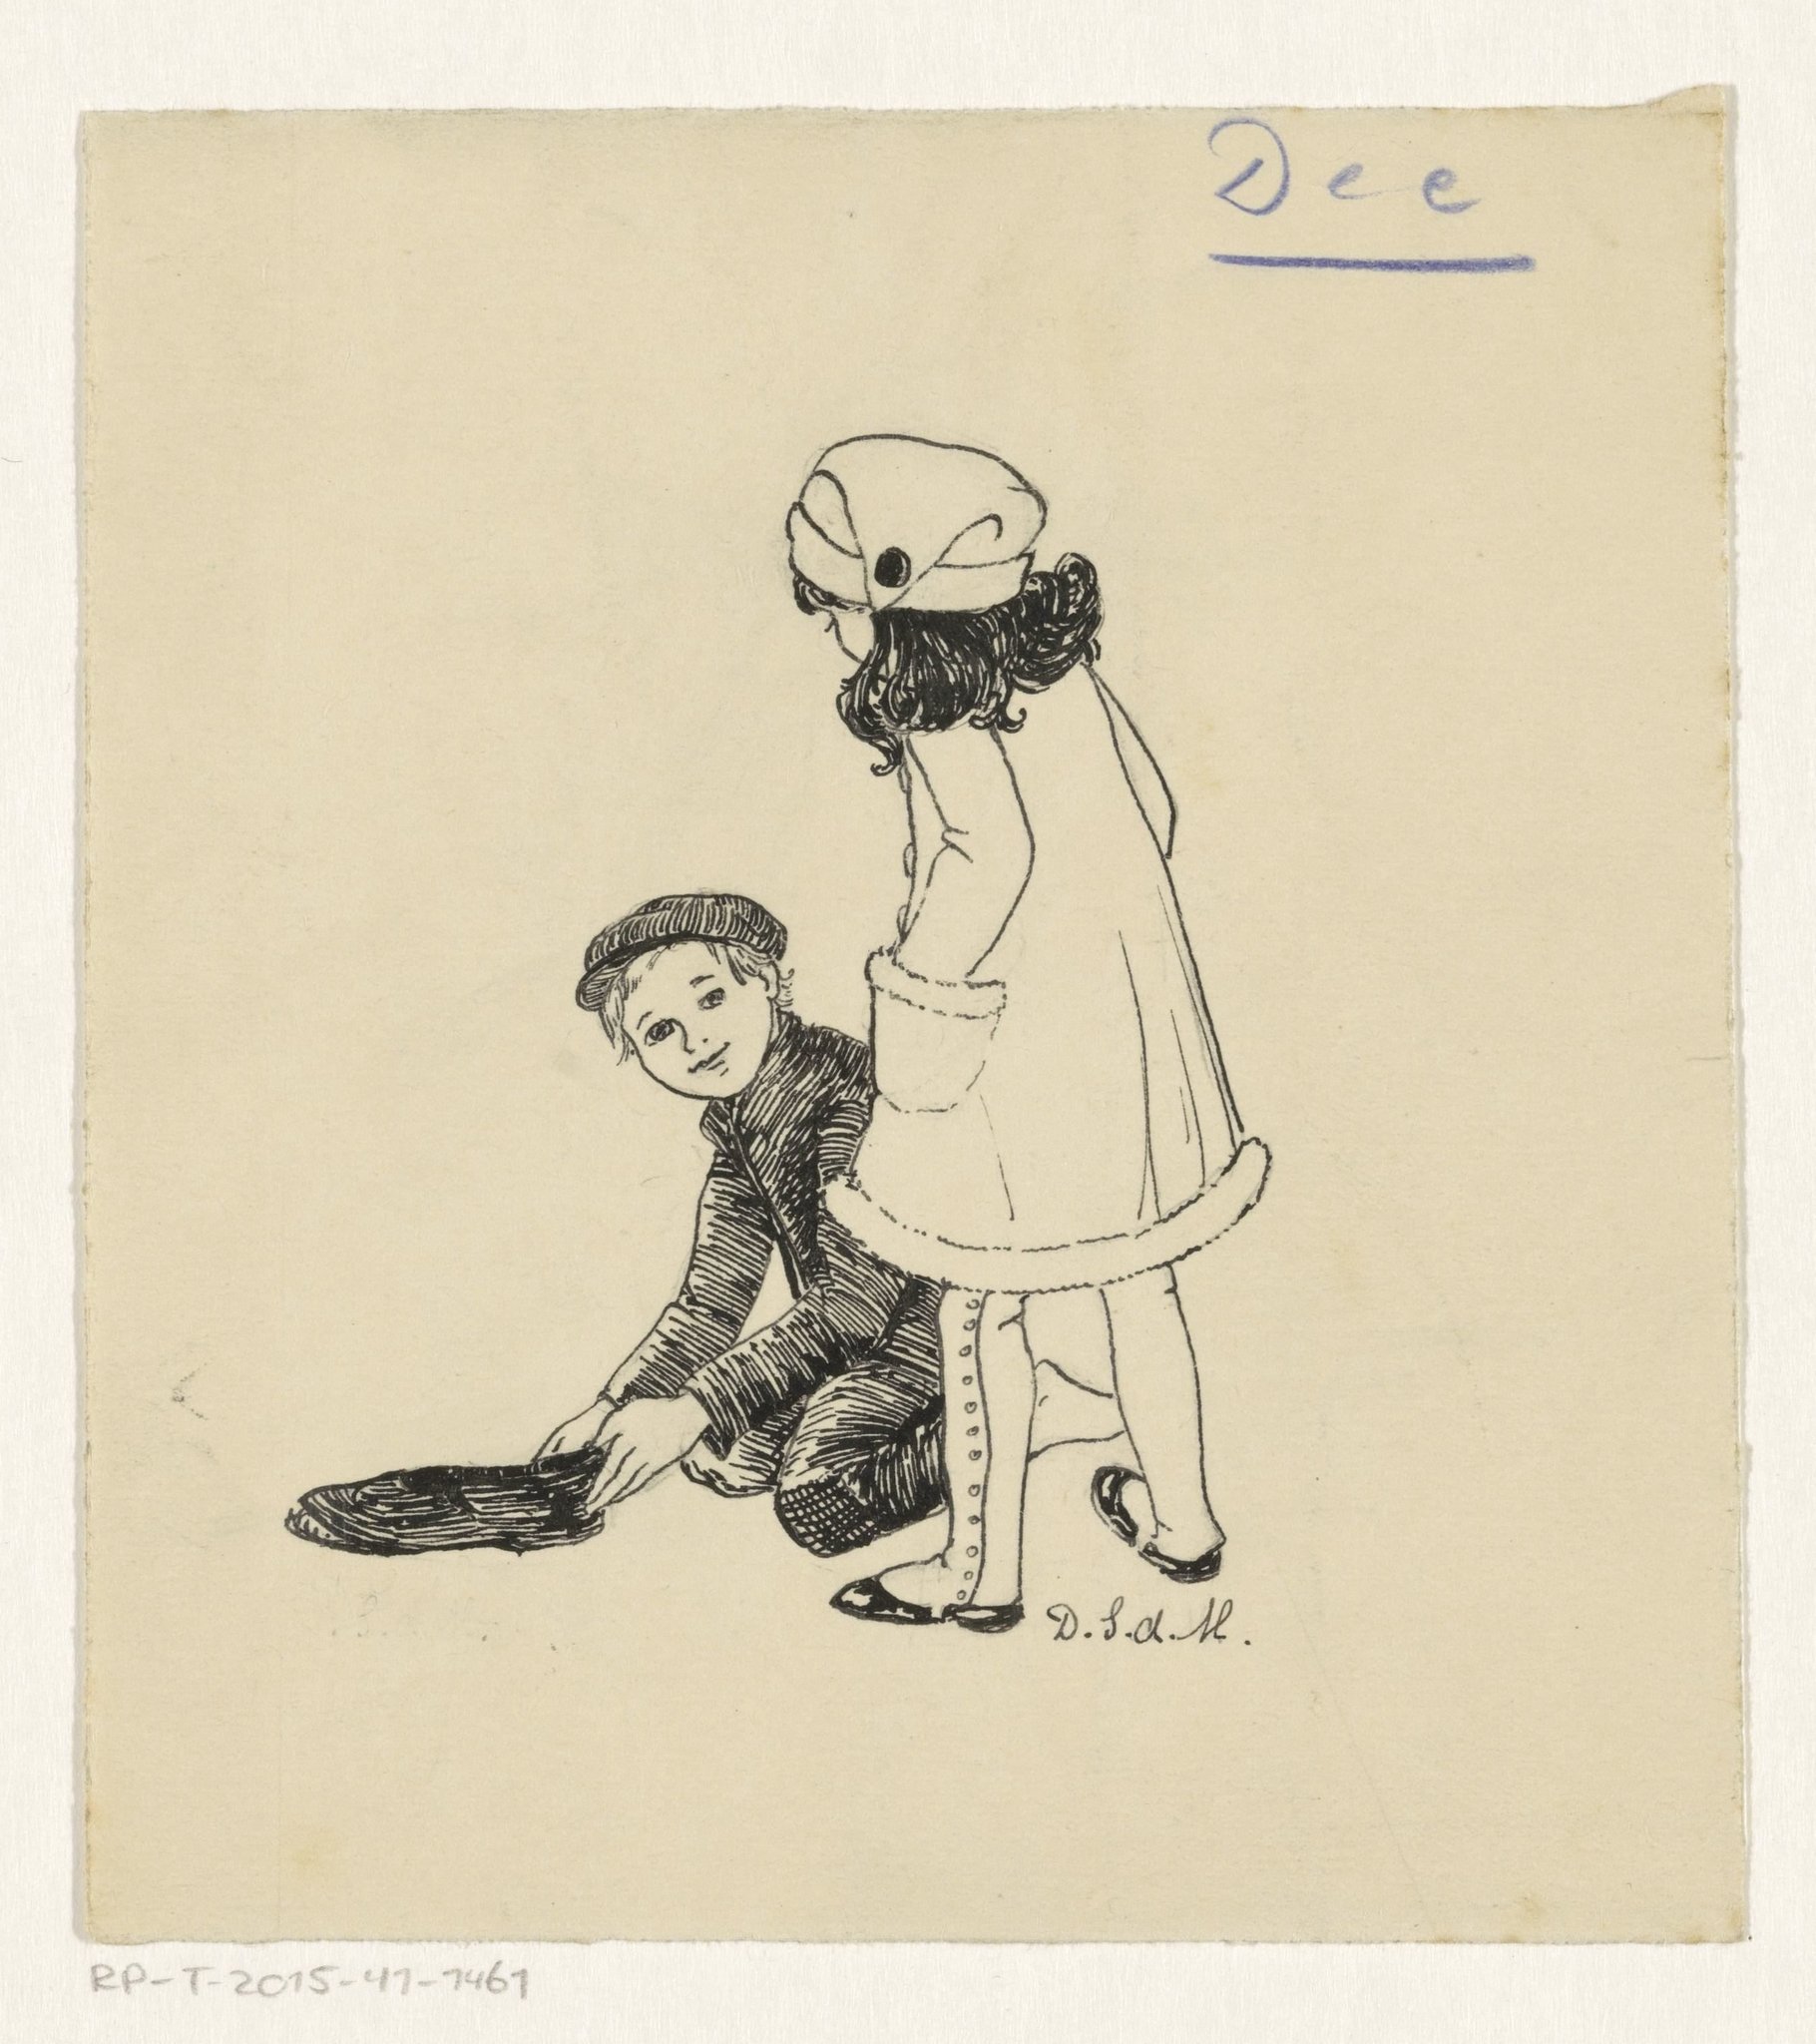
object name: boekillustratie ontwerp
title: Jongen en meisje met een schoen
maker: dora struick du moulin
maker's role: draughtsman, print maker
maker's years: 1866-1937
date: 1896-1937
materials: ink, paper, pencil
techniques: pen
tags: shoes, sandals, kneeling figure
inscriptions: annotation: ‘Dec’, monogram: ‘D.S.d.M.’, collector's mark: Lugt 2228, :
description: Een jongen knielt bij een schoen en kijkt op naar een meisje dat naast hem staat.